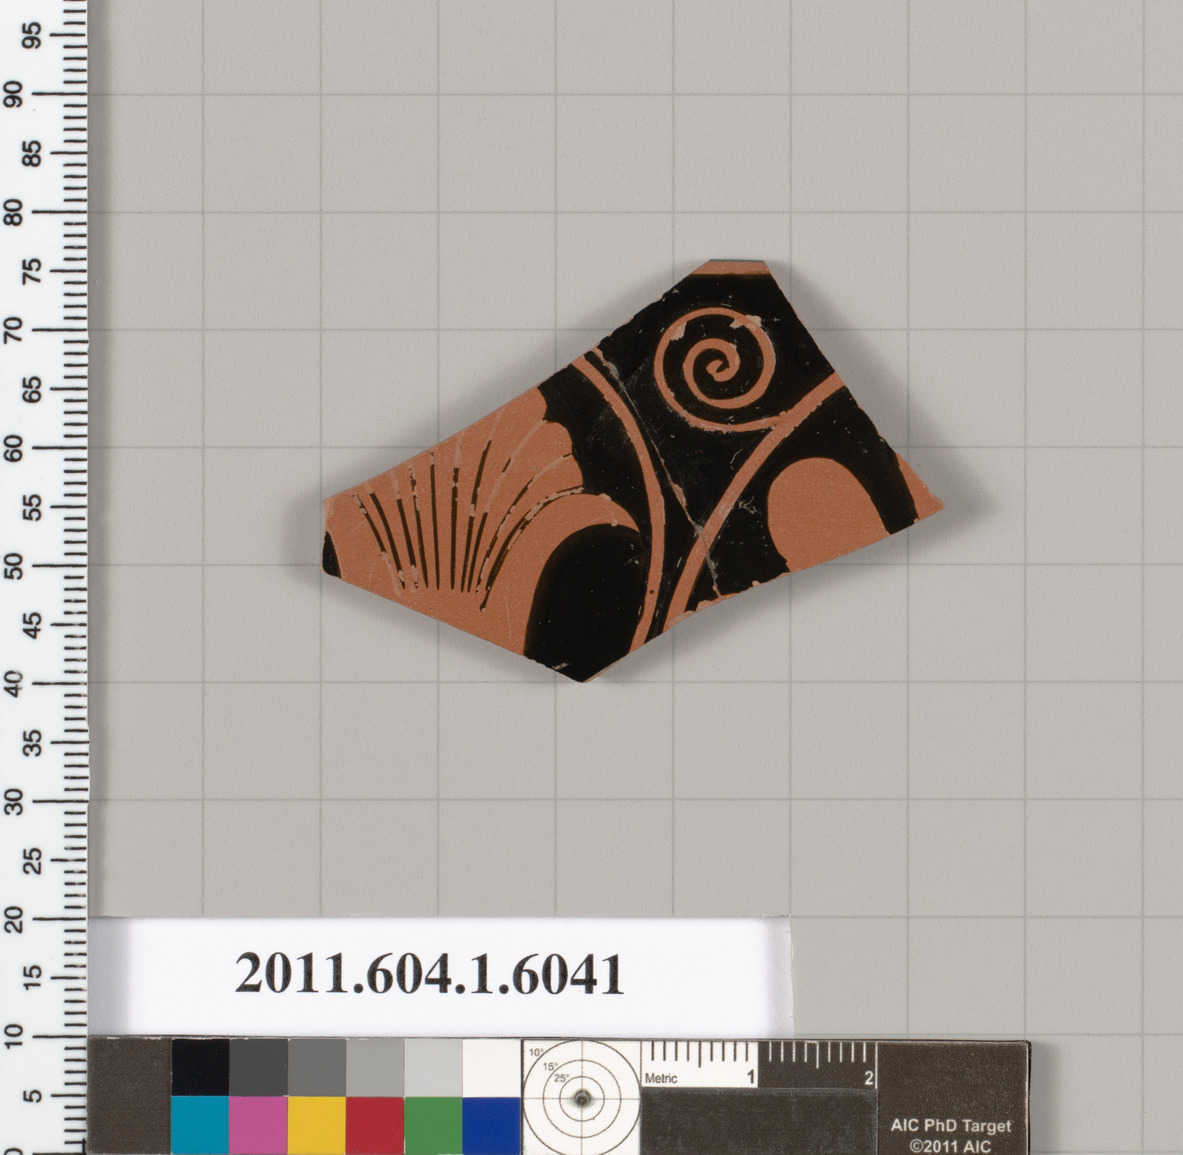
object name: kylix fragment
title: Terracotta rim fragment of a kylix (drinking cup)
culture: greek, attic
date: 510-500 BCE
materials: terracotta